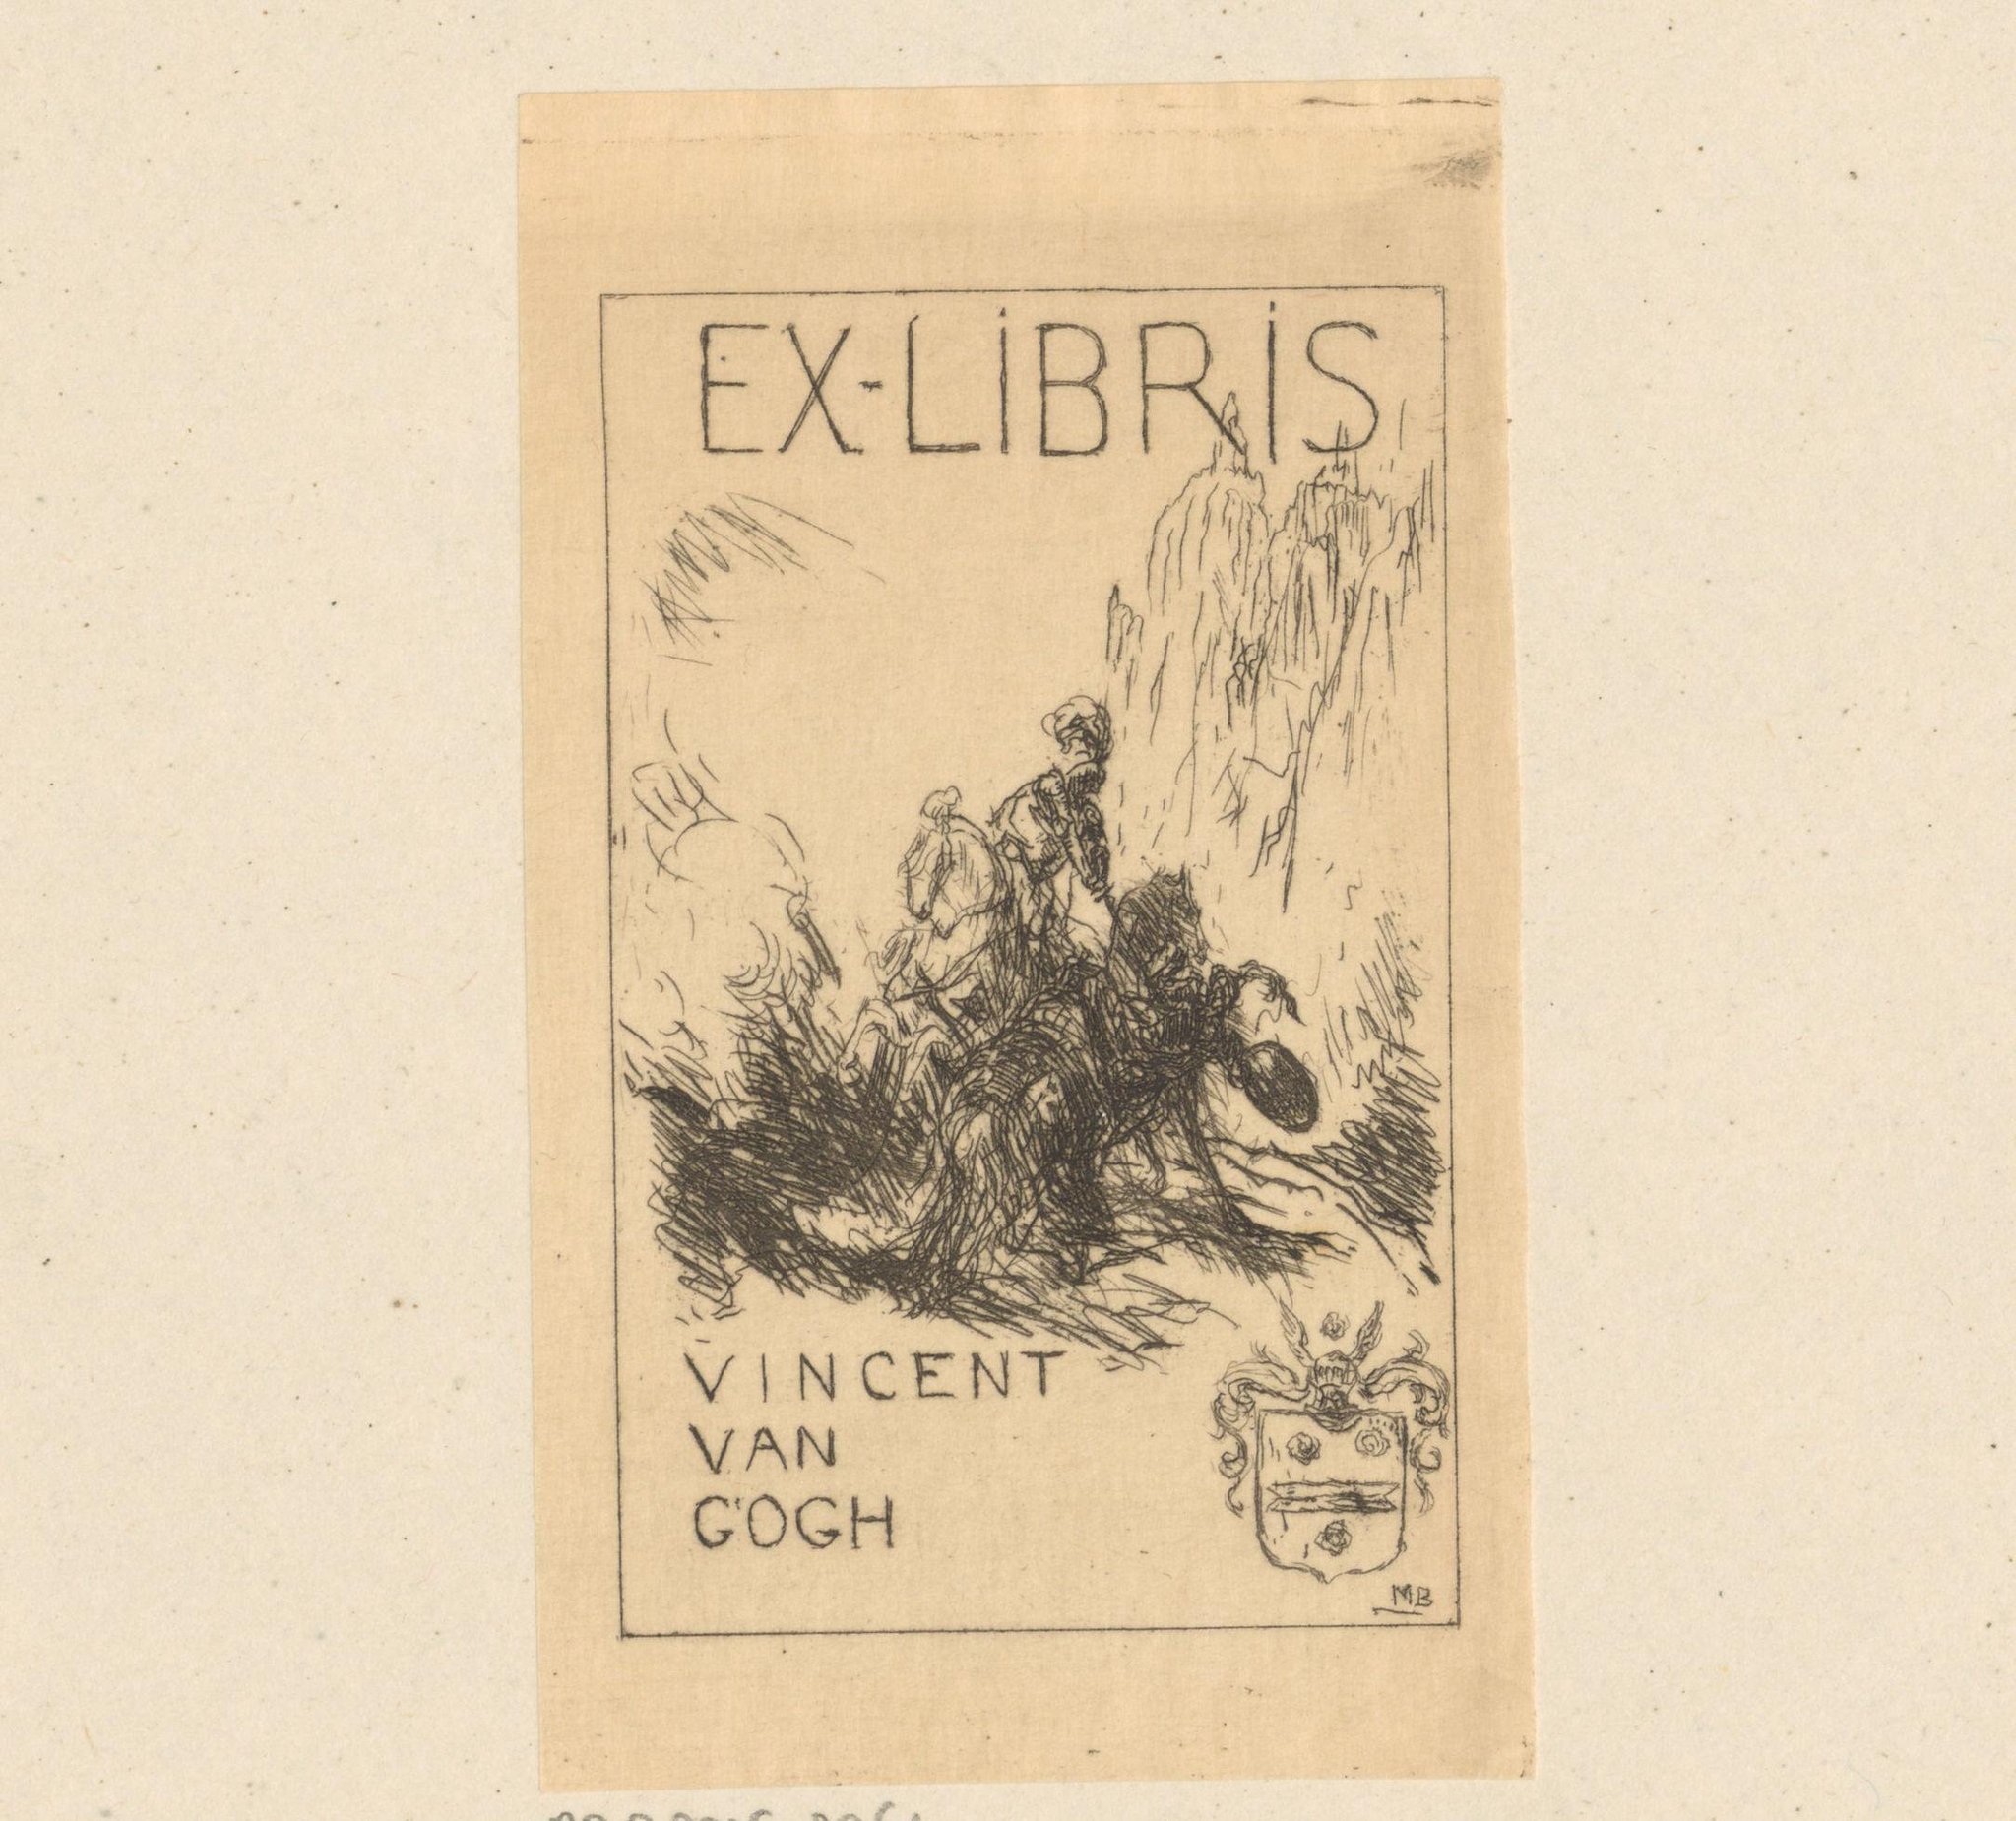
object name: bookplate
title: Ex libris van Vincent van Gogh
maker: marius bauer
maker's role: draughtsman, print maker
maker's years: 1867-1932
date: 1877-1911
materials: paper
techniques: etching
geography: netherlands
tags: amsterdam, riding a horse, ass, or mule; rider, horseman, sabre (~ fencing), armorial bearing, heraldry